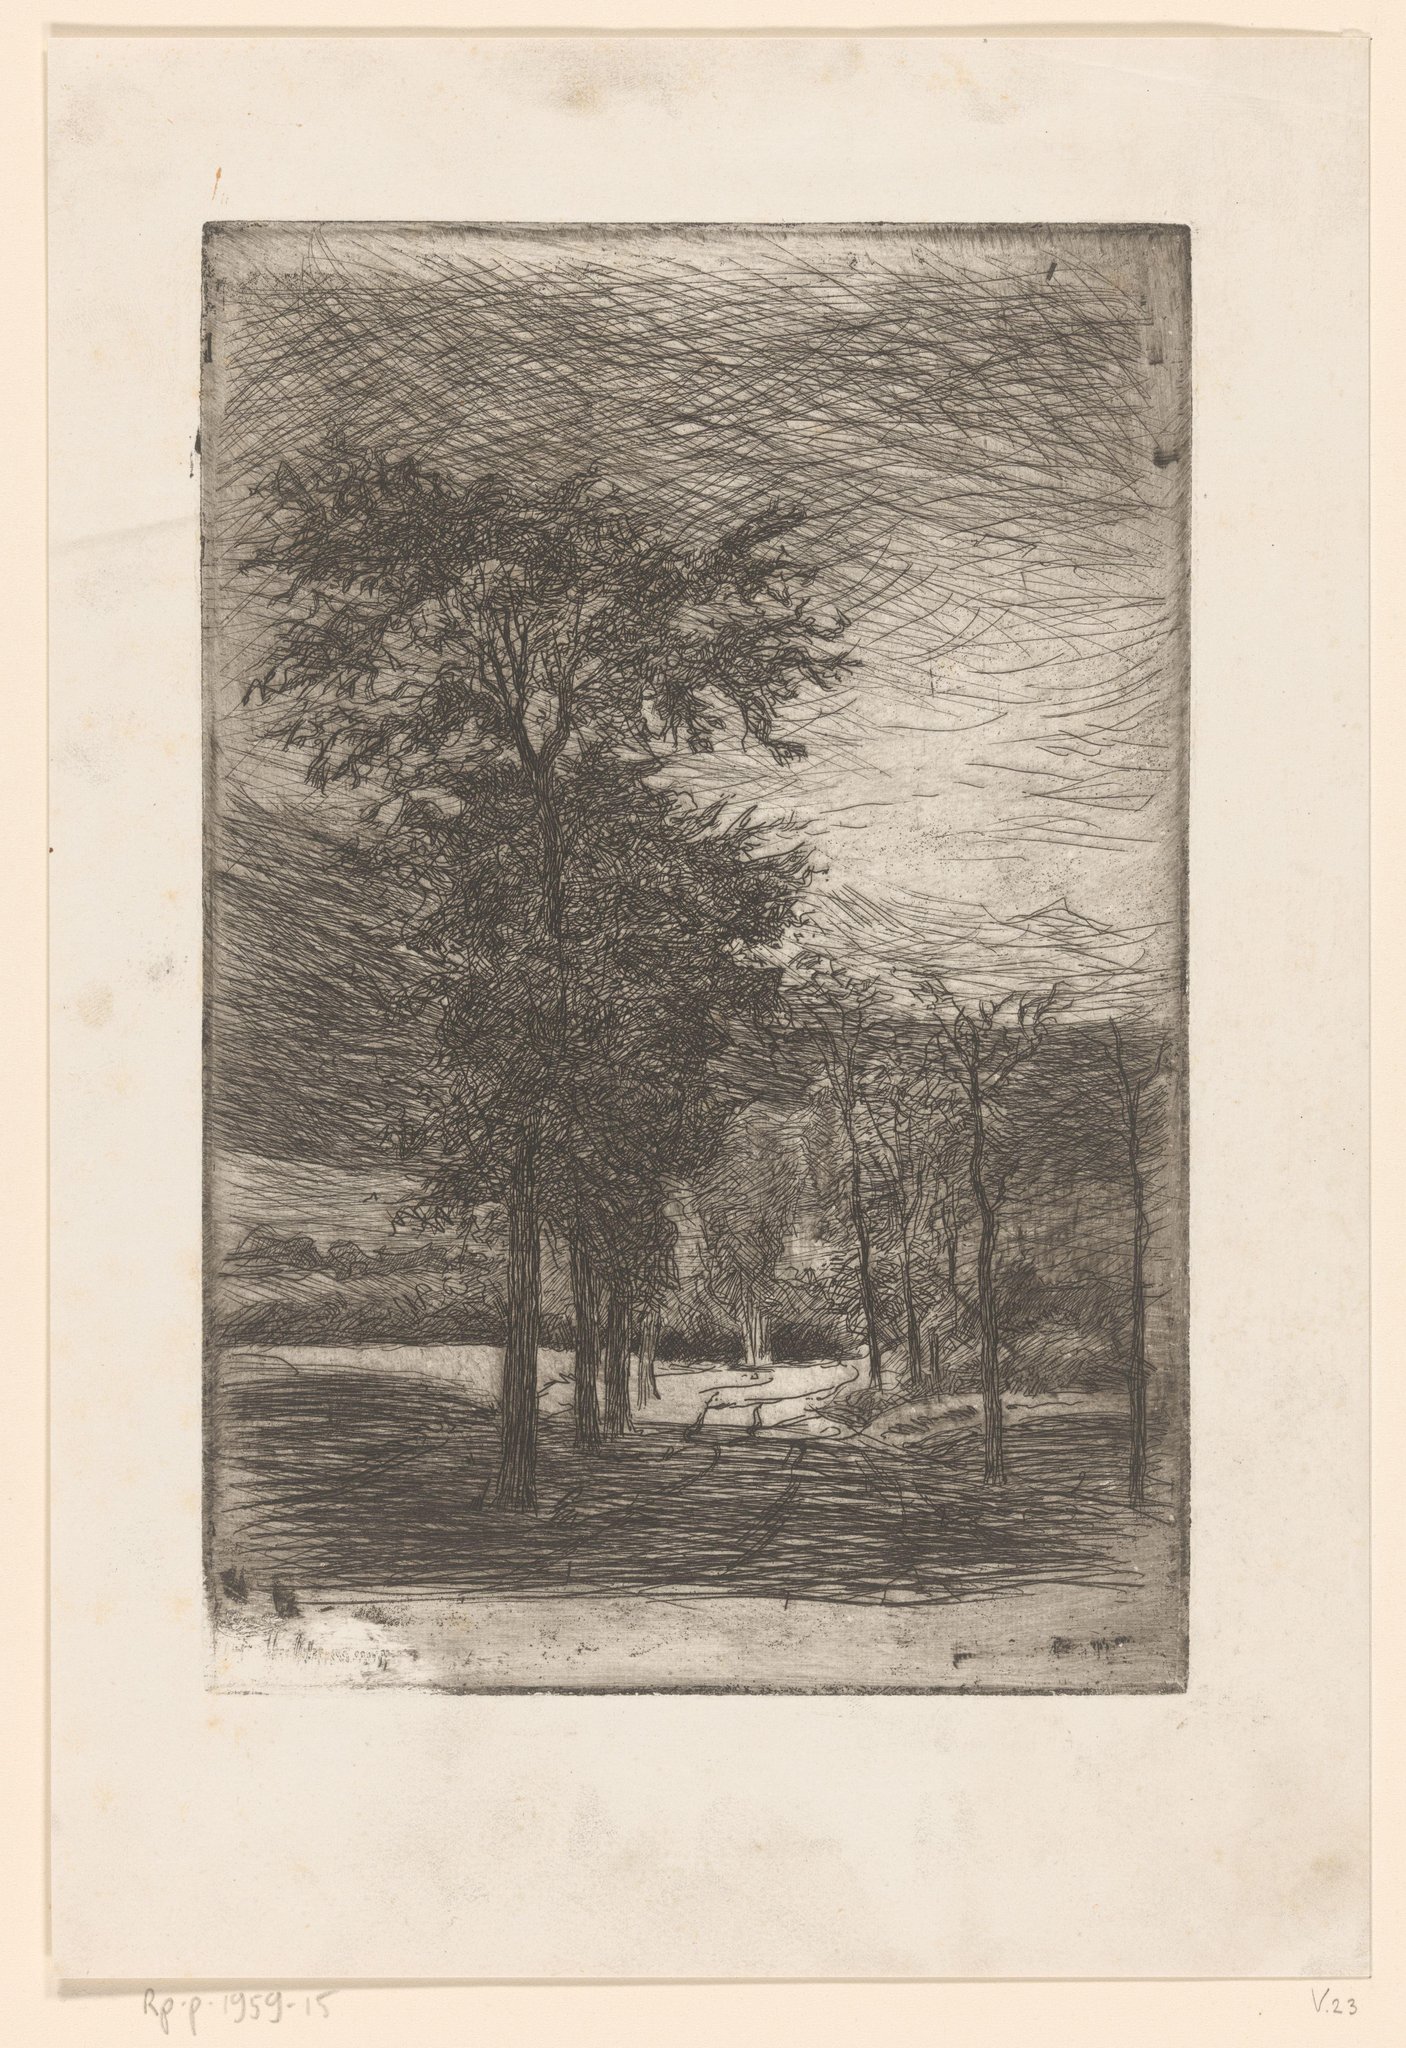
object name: print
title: Weg tussen bomen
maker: jan veth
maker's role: designer, draughtsman, painter, print maker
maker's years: 1864-1925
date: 1886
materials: paper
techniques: etching, intaglio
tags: road, path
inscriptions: collector's mark: Lugt 2228